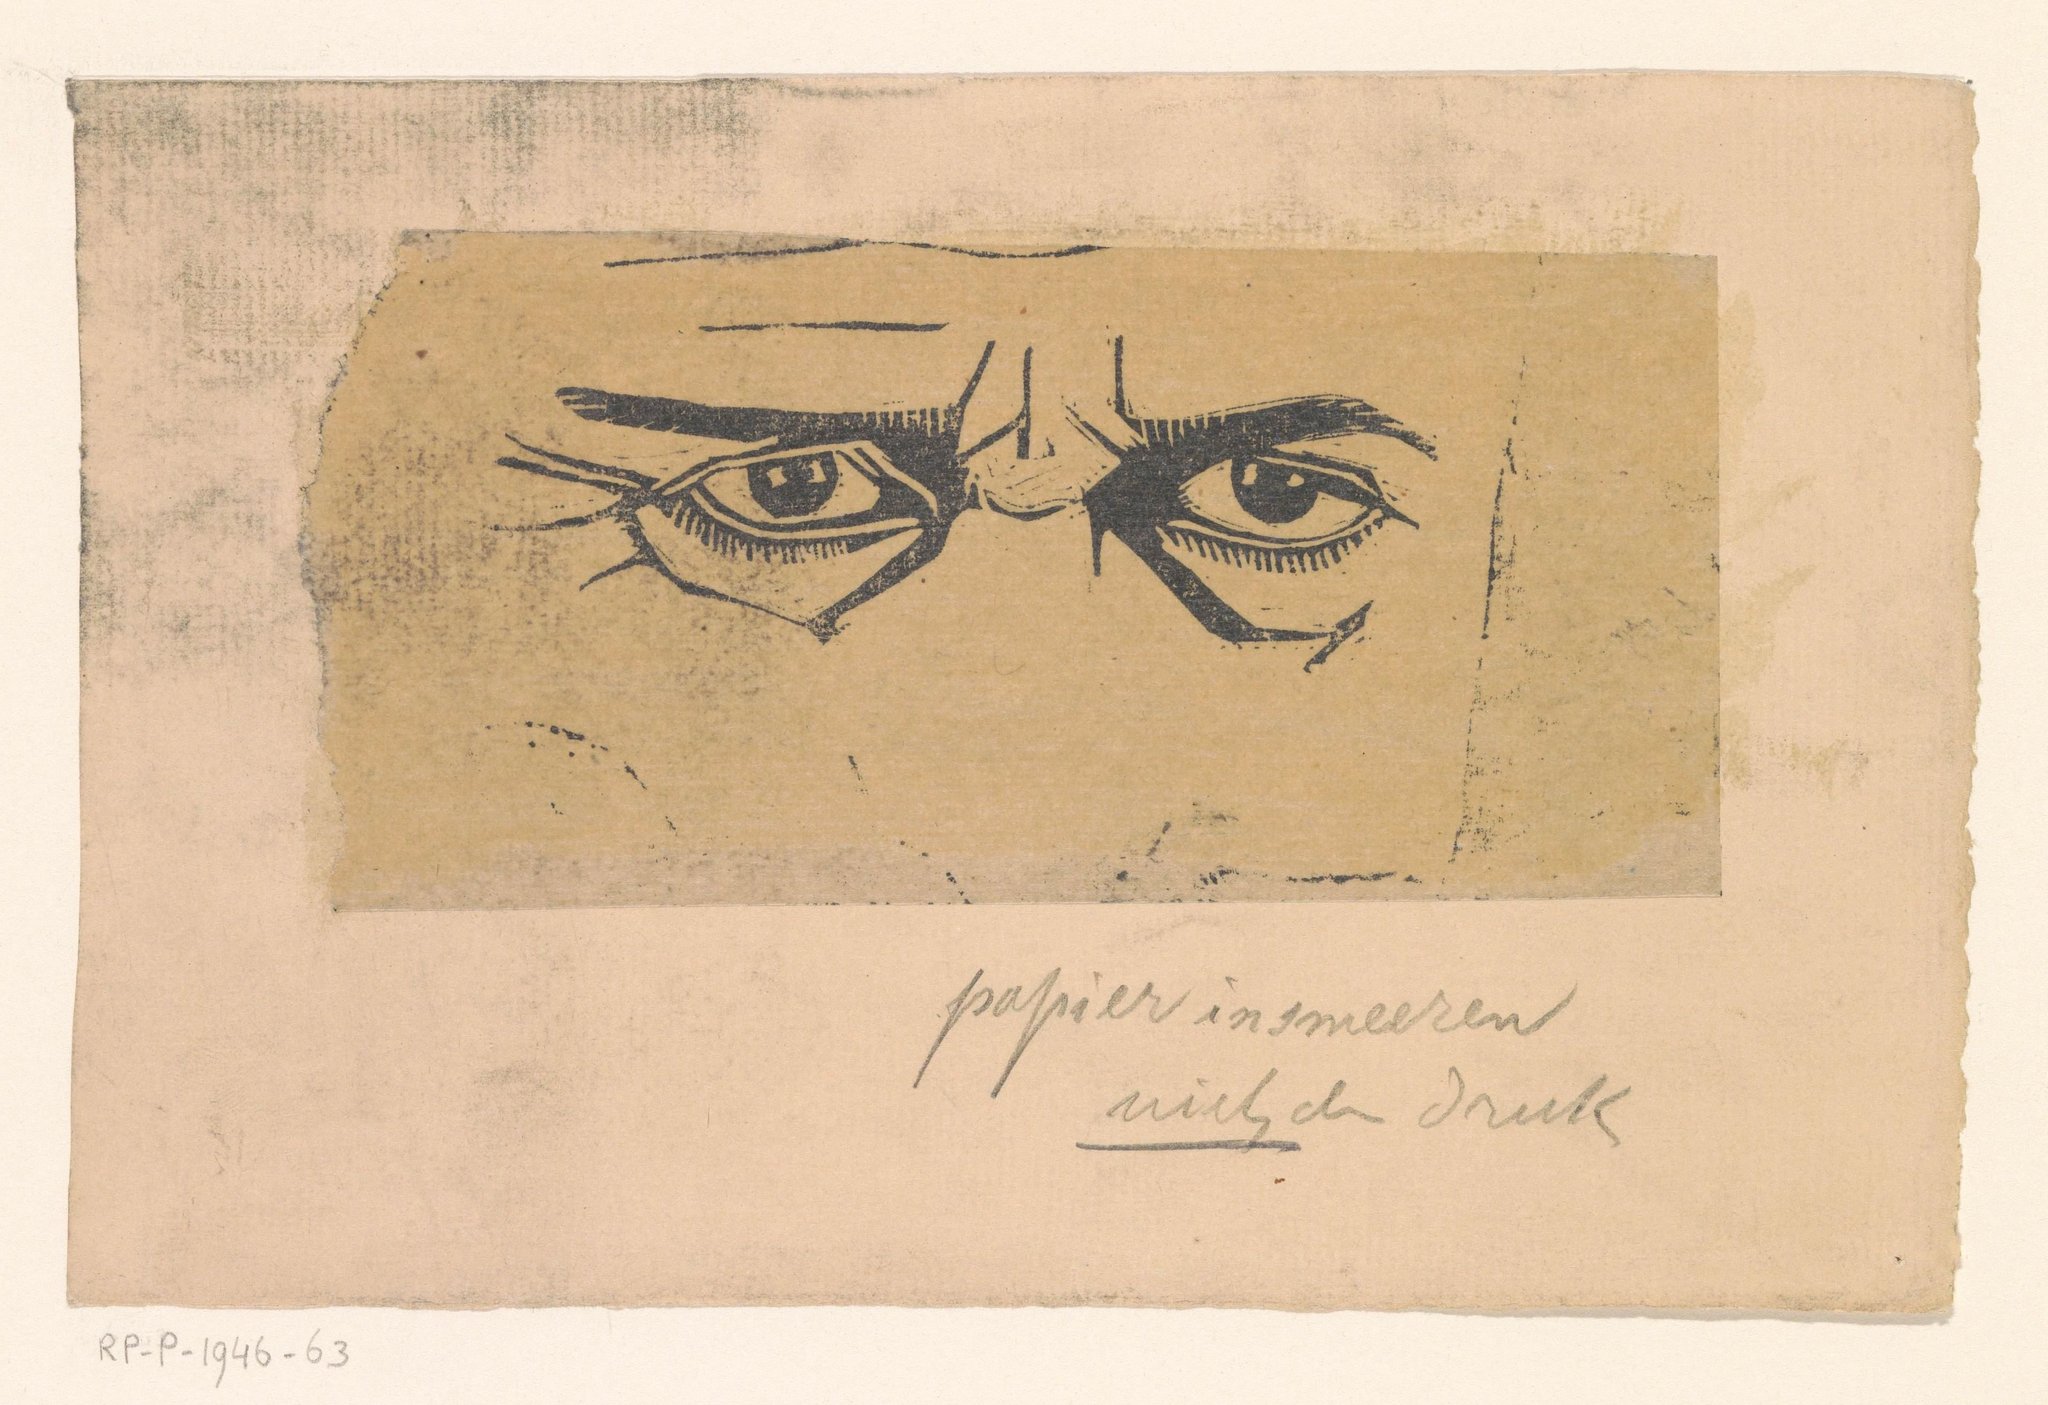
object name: print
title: Zelfportret van alleen de ogen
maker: samuel jessurun de mesquita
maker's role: draughtsman, print maker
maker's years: 1868-1944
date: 1917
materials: paper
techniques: woodcut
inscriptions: inscription: ‘papier insmeeren/ niet den druk’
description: Zelfportret van alleen de ogen, een diepe frons tussen de wenkbrauwen.